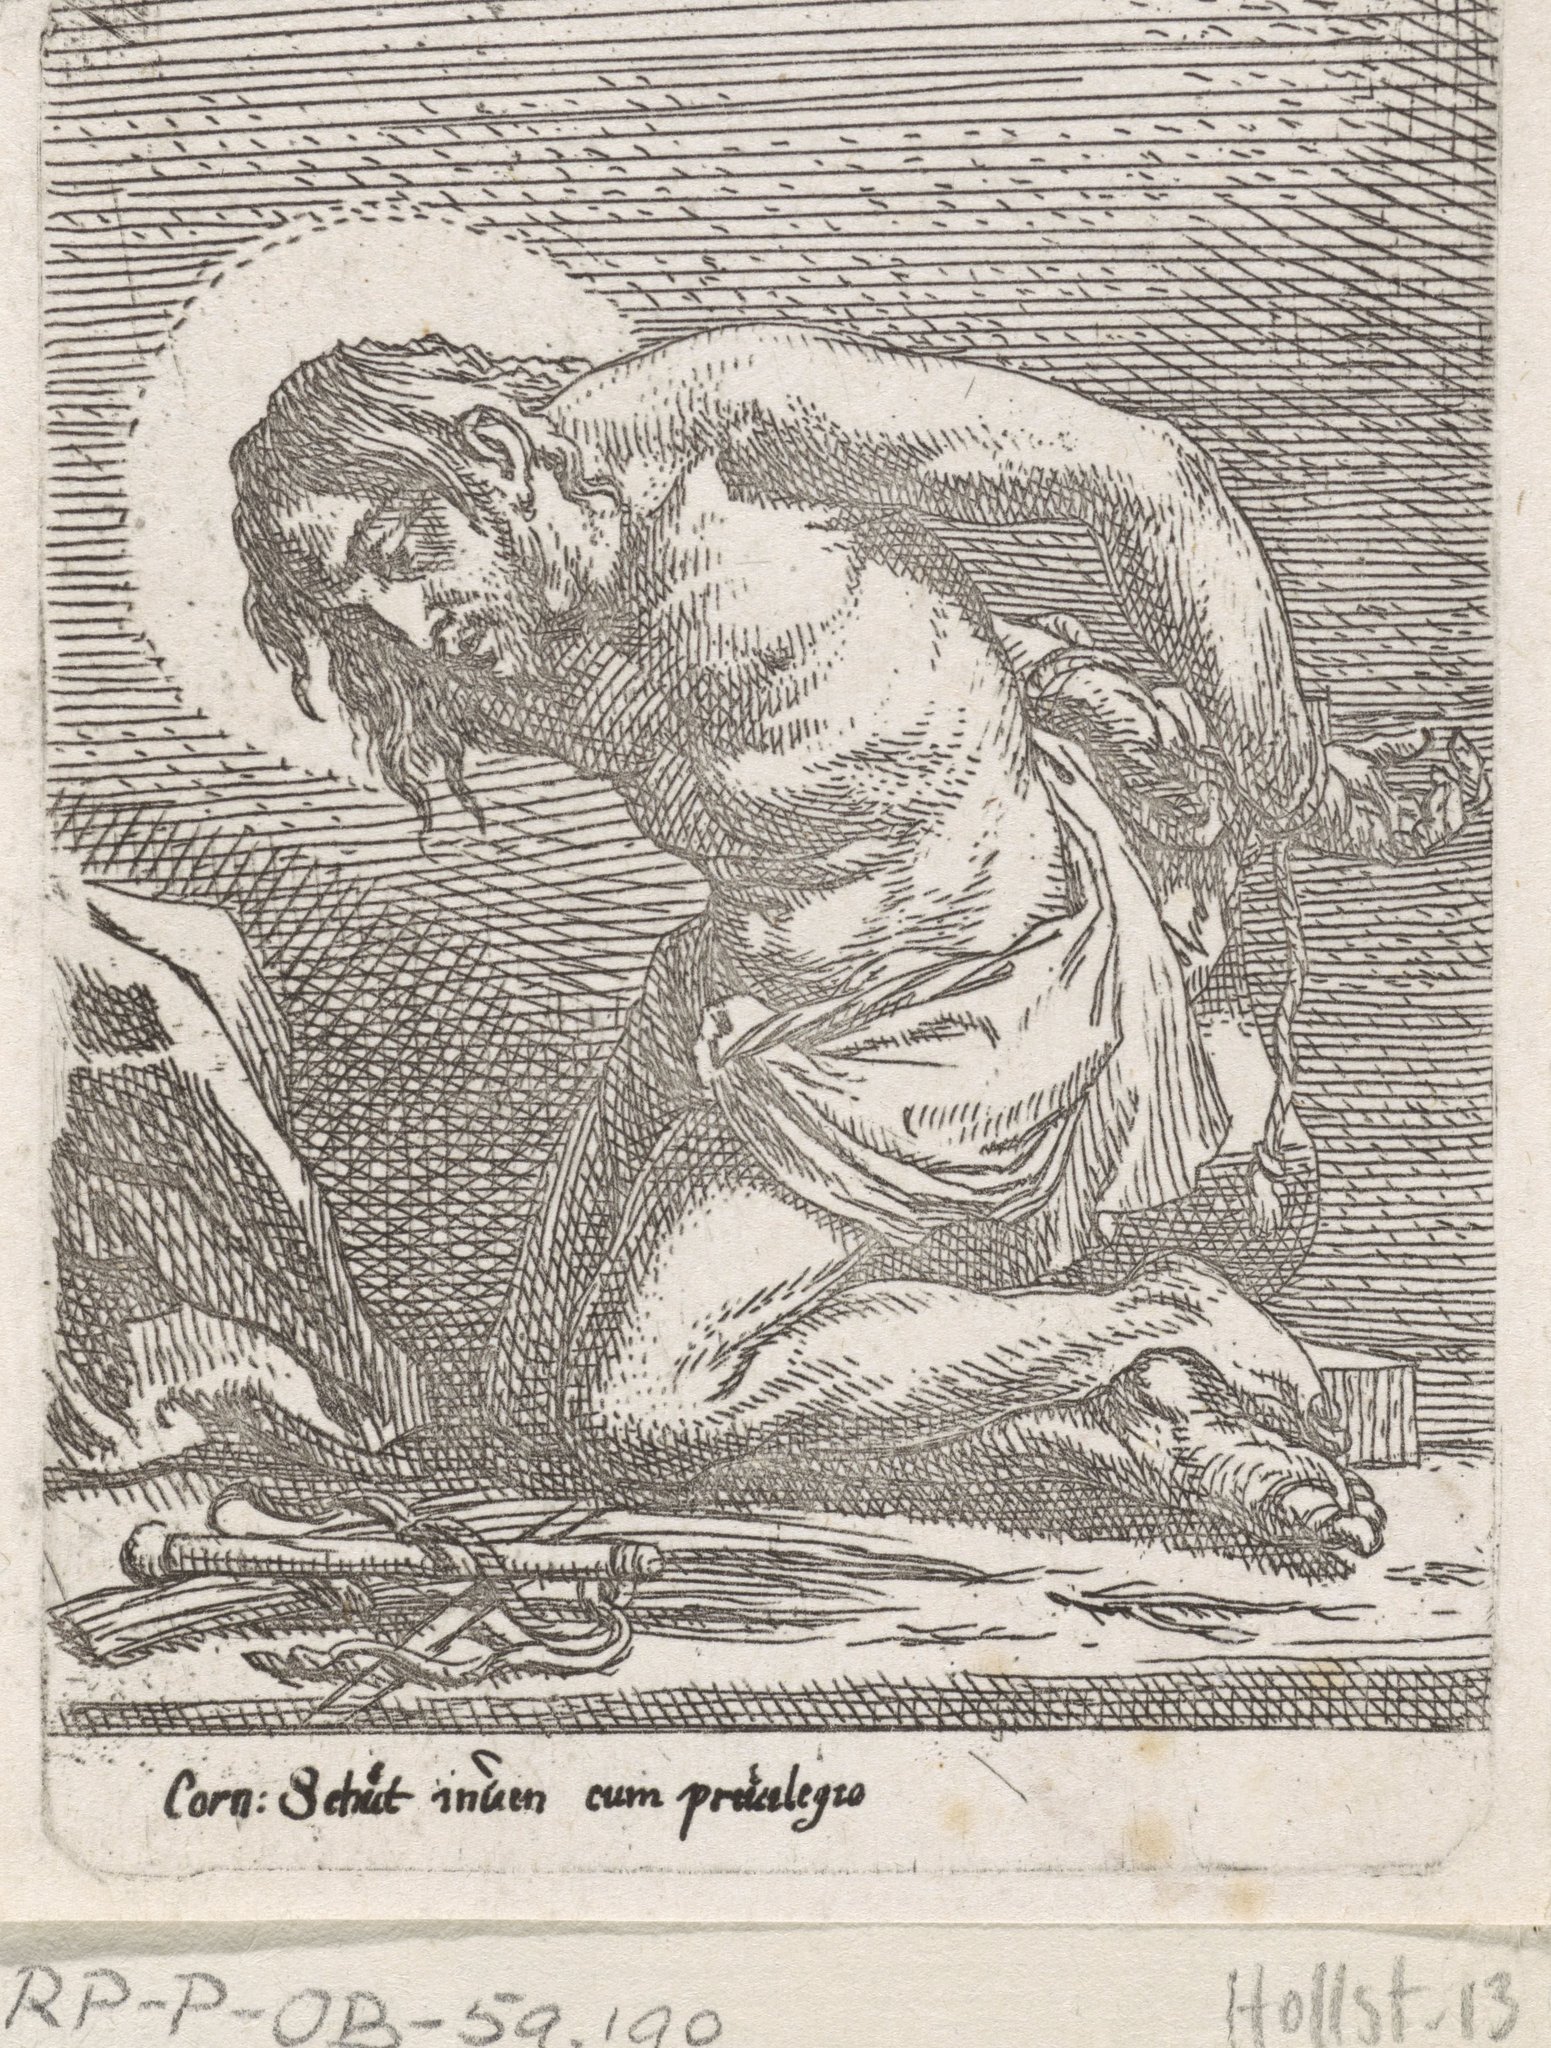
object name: print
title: Christus aan de geselpaal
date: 1618-1655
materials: paper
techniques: etching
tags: flagellation by soldiers, christ usually tied to a column (matthew 27:26; mark 15:15; john 19:1)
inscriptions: collector's mark: Lugt 240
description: Christus zit na de geseling op zijn knieën, zijn handen nog vastgebonden aan de geselpaal; op de grond liggen zijn kleding en martelwerktuigen.